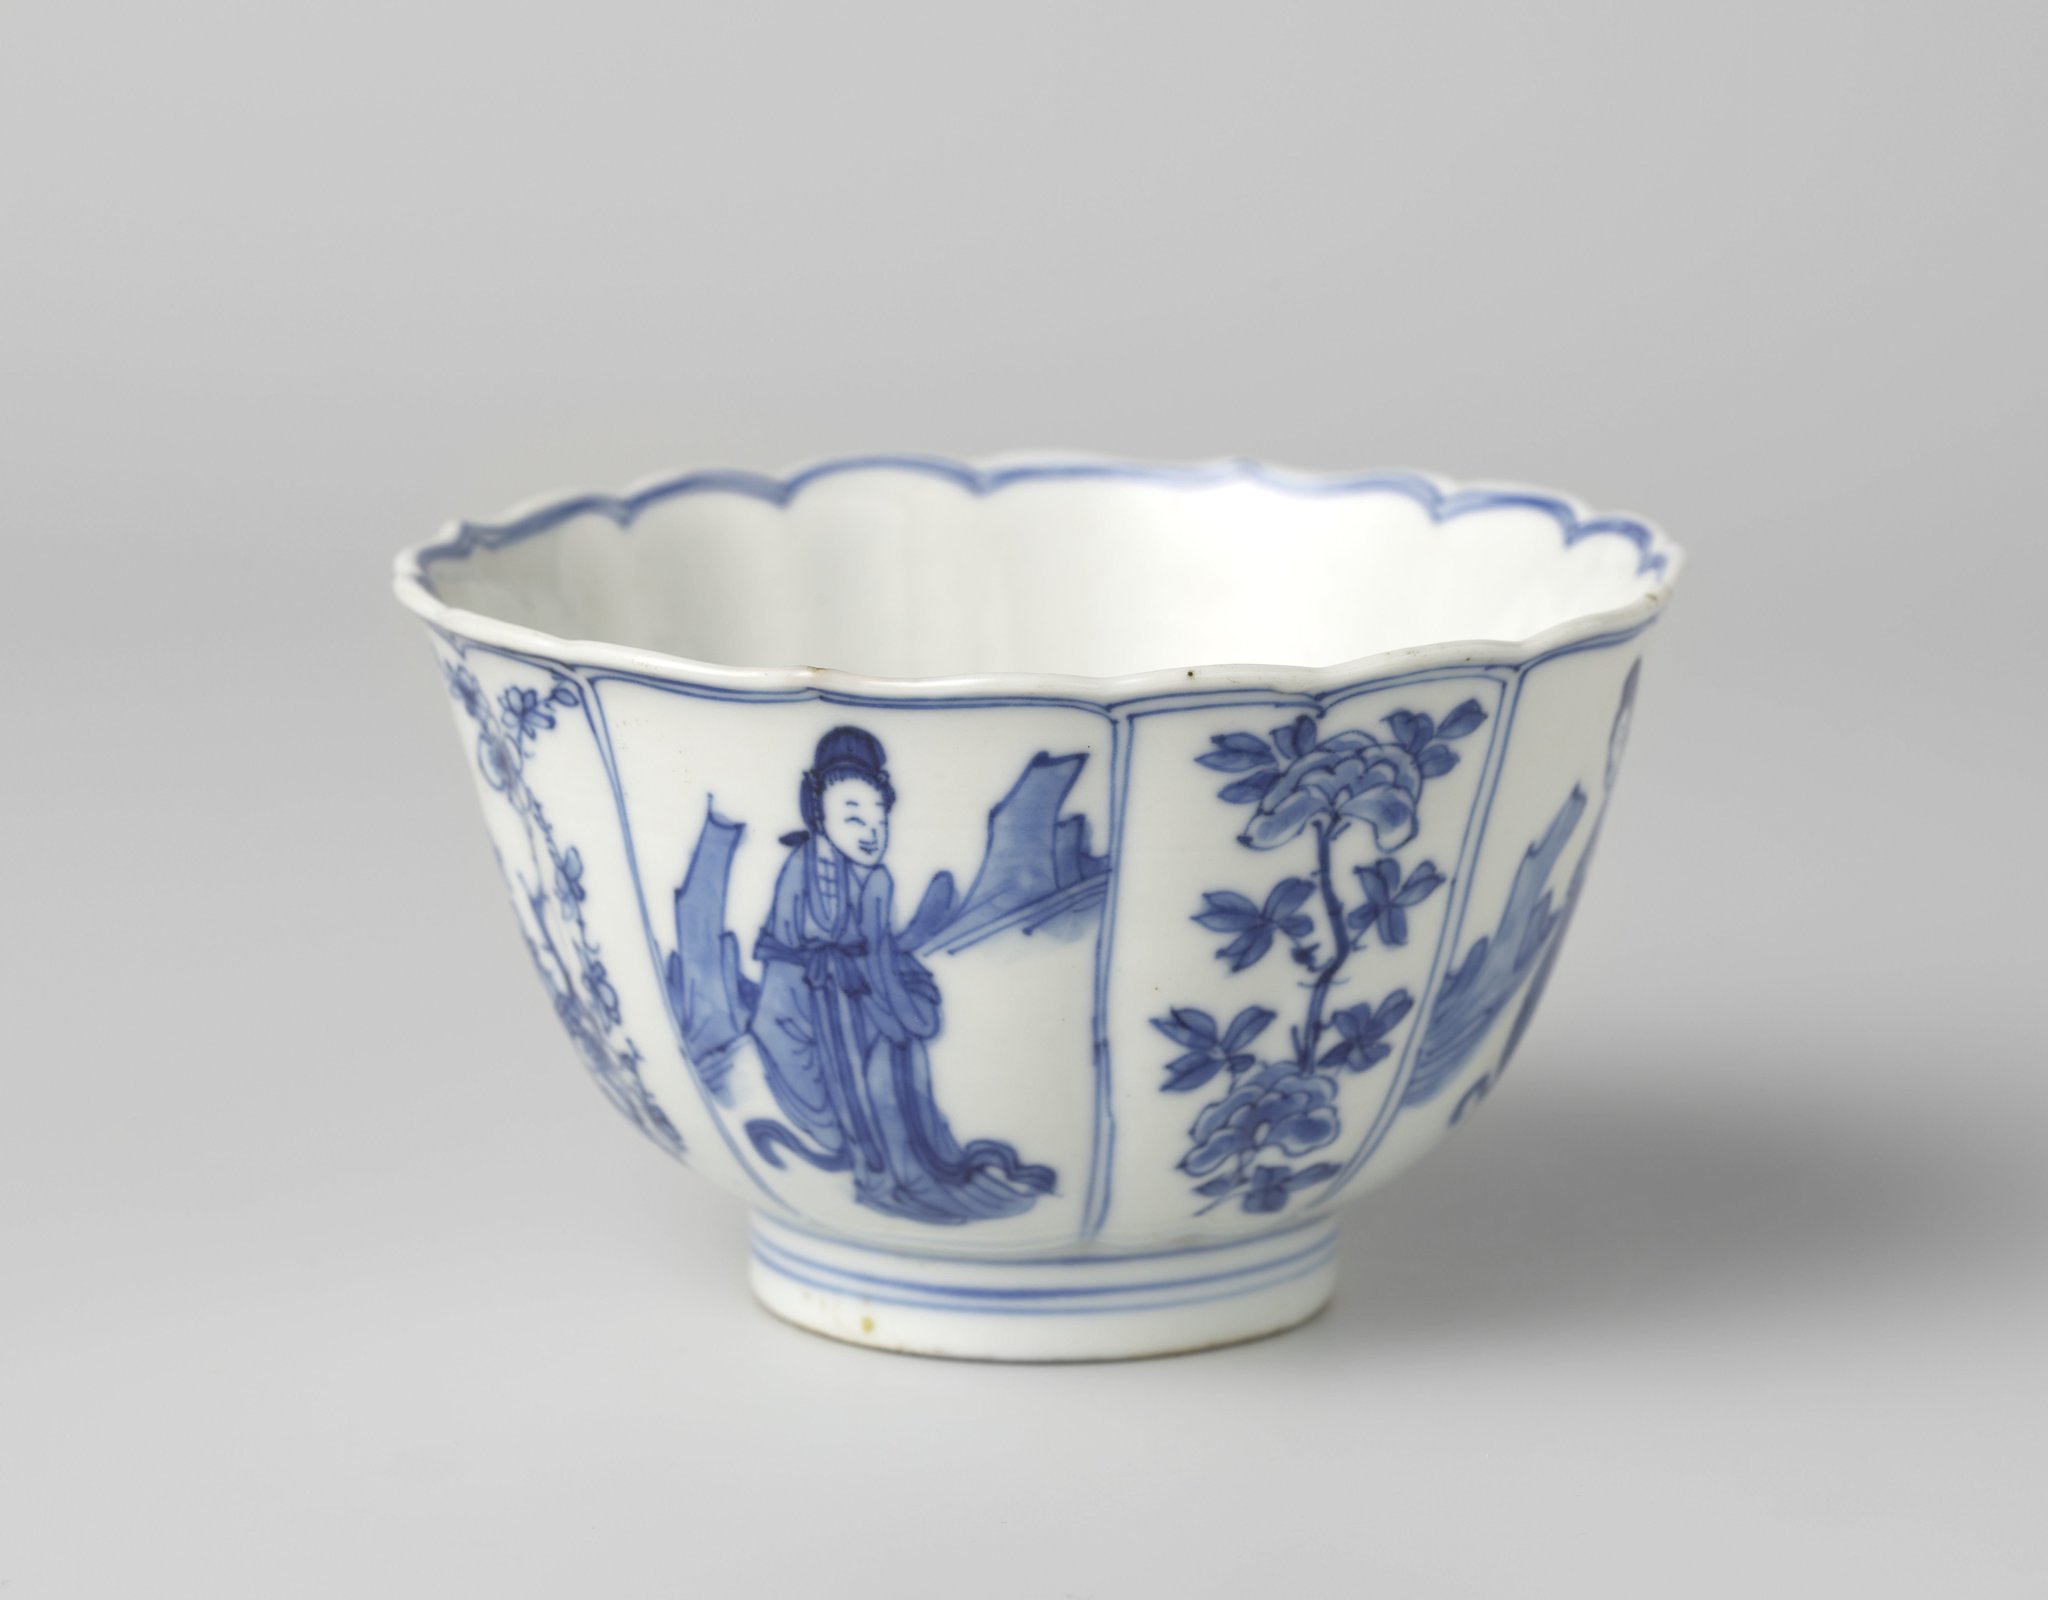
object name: bowl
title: Bell-shaped bowl with women and flower sprays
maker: Anonymous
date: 1680-1720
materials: cobalt, glaze, paint, porcelain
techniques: firing, turning, vitrification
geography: china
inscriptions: mark: ‘大 明 成 化 年 製’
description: Klokvormige kom van porselein, met gelobde wand en geschulpte rand, beschilderd in onderglazuur blauw met een vakdecoratie. Op de buitenzijde van de kom acht vakken met afwisselend een vrouw, één met een waaier, in een landschap en bloemtakken zoals pioen, prunus en camelia; op de bodem een zittende vrouw. Gemerkt op de onderzijde met het zes-karaktermerk van keizer Chenghua in een dubbele cirkel. Een chip in de rand. Blauw-wit.